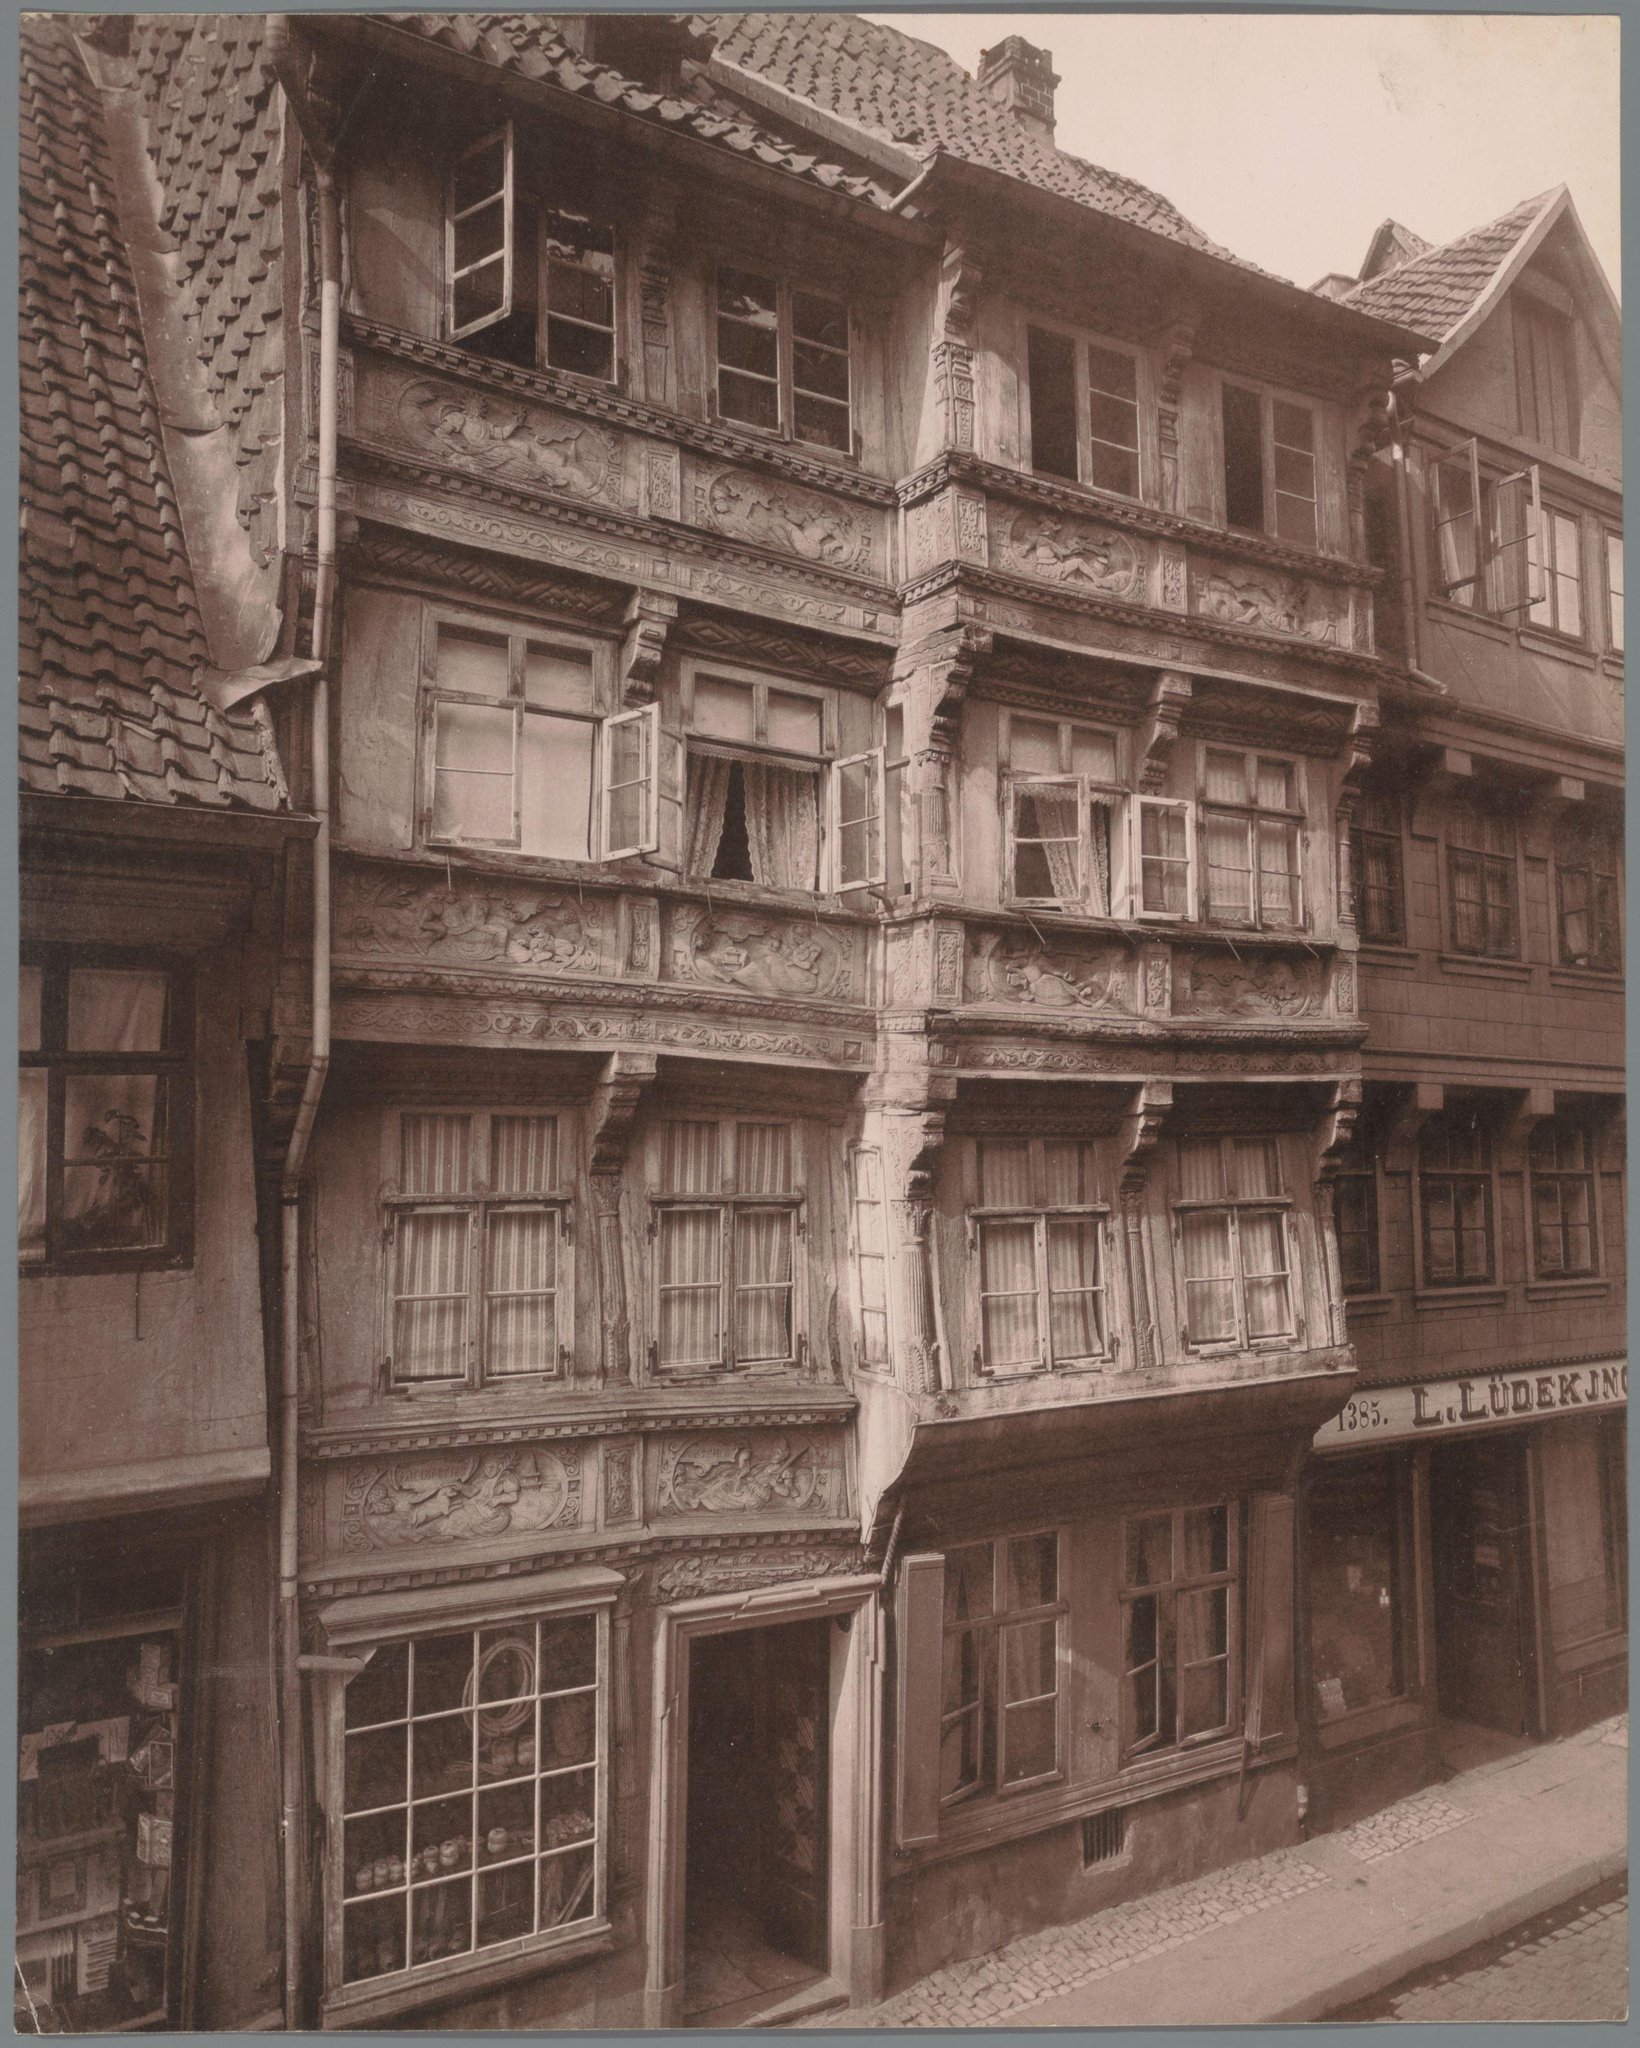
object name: photomechanical print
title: Straatgezicht in Hildesheim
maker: Anonymous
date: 1880-1900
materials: paper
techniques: photograph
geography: hildesheim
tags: house combined with shop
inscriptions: number: ‘N.11’, inscription: ‘Hildesheim’